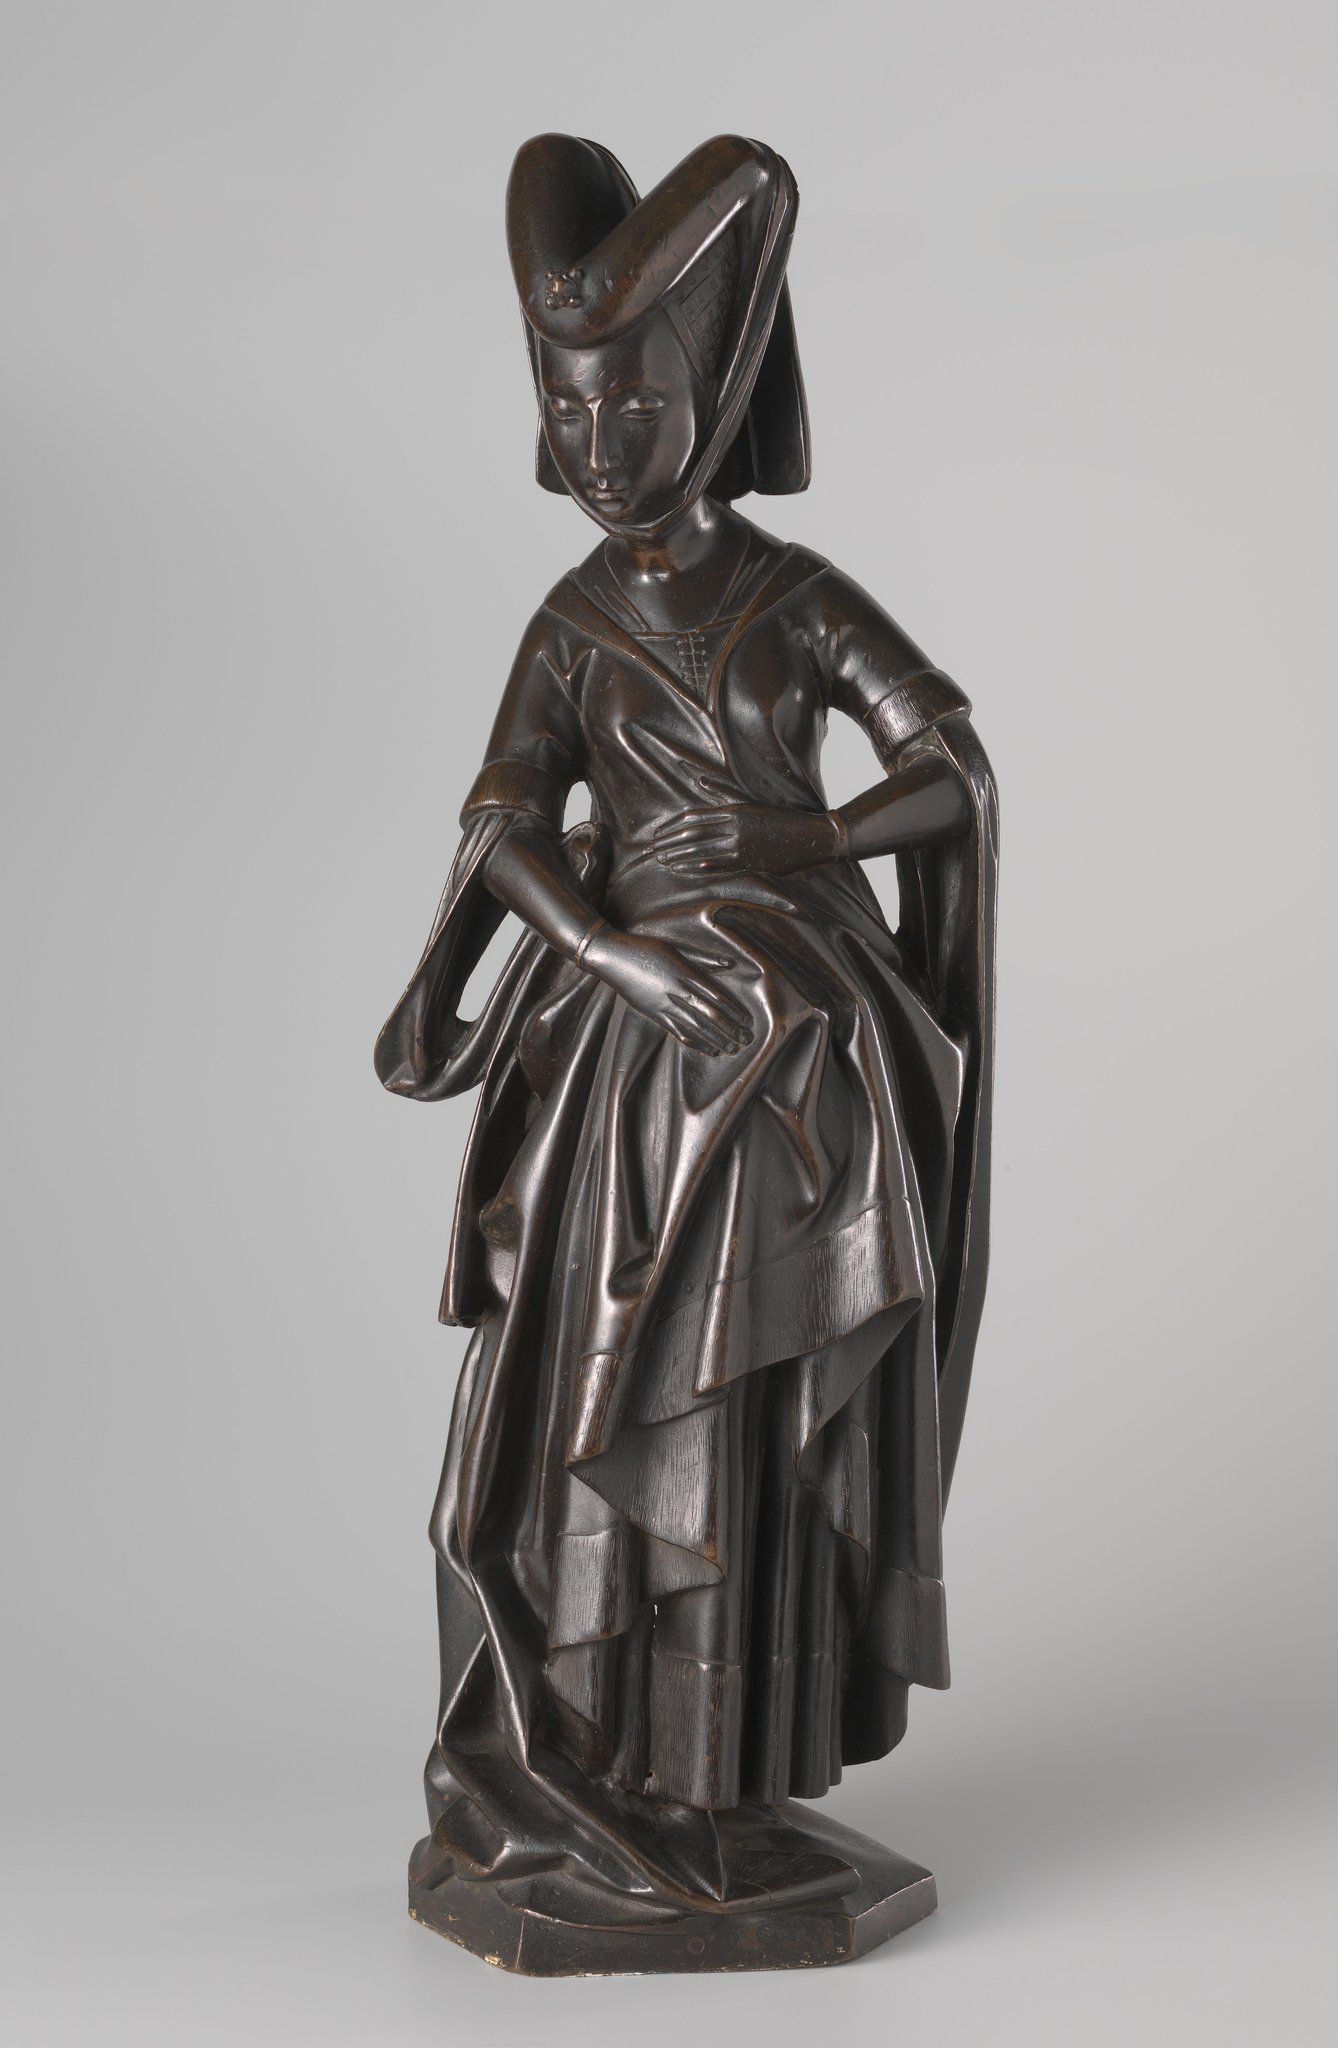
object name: tomb figure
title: Female Weeper Wearing a V-Shaped Bourrelet on her Head, from the Tomb of Isabella of Bourbon (1436-1465)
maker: renier van thienen (i)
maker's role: brazier, caster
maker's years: 1465-1498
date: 1475-1476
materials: bronze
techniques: casting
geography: brussels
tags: 'pleurants', clothes, costume (+ women's clothes), nobility and patriciate; chivalry, knighthood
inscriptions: inscription, on the back, at the bottom, incised after casting and finishing: indistinguishable location mark, number, on the back, at the top, in modern white paint: ‘1’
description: Mary of Burgundy had a mausoleum erected for her late mother, Isabella of Bourbon. Only the gisant (tomb effigy) of Isabella and 10 of the 24 figures originally surrounding the tomb have been preserved. These pleurants (weepers) represent five generations of grieving forebears. While the tomb commemorated Isabella, it mainly served to advertise Mary’s noble lineage. She was the sole remaining heir of the Dukes of Burgundy and therefore a highly desirable consort. A year after the monument was completed, she married Maximilian of Habsburg, whereby the Burgundian Netherlands became part of the vast Holy Roman Empire.